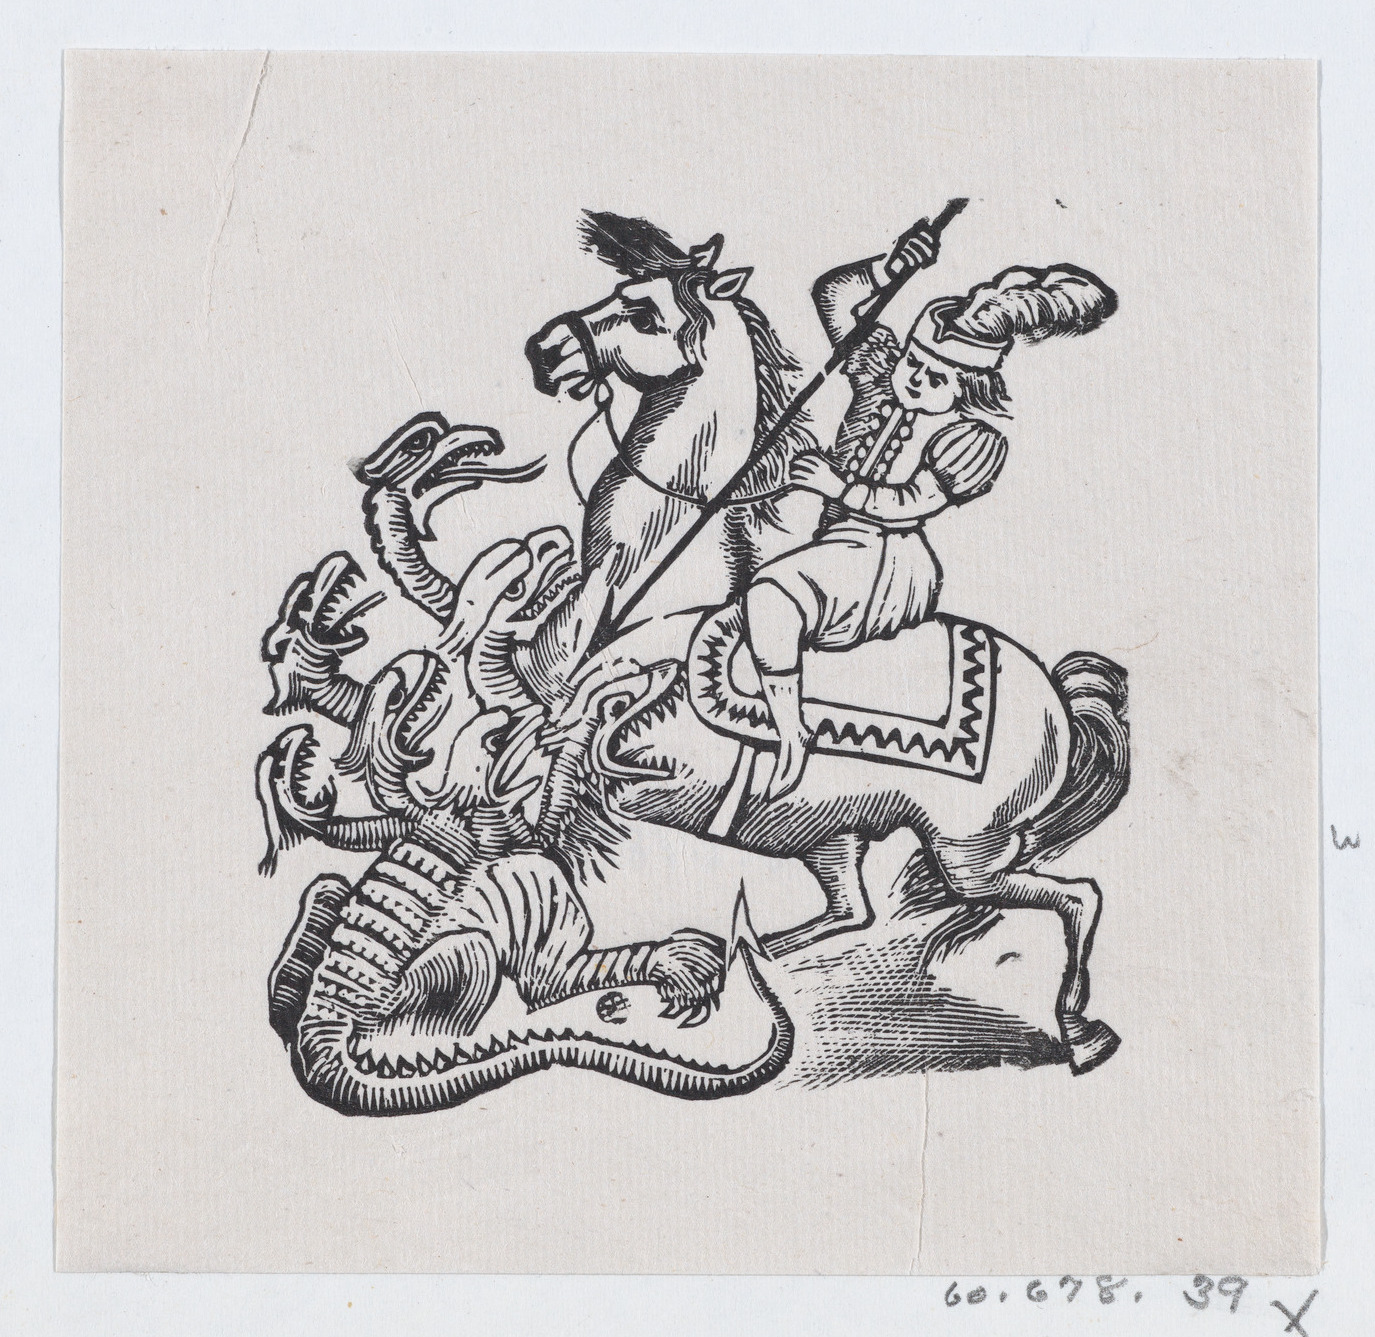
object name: print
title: A man on horseback stabbing a monster with a lance, illustration from 'The King and His Three Sons'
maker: josé guadalupe posada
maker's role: artist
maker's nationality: mexican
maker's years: 1852-1913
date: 1880-1910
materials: metal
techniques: engraving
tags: men,monsters,horses